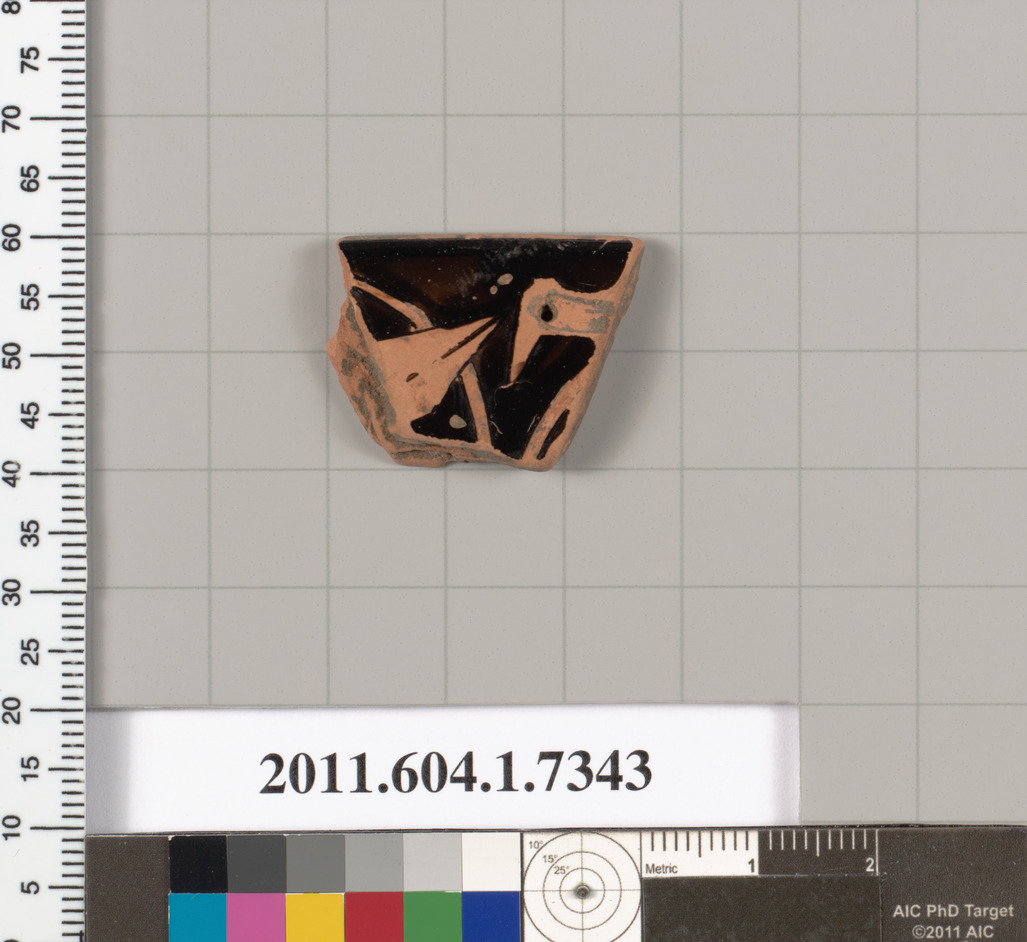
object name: kylix fragment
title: Terracotta rim fragment of a kylix (drinking cup)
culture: greek, attic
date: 500-480 BCE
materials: terracotta